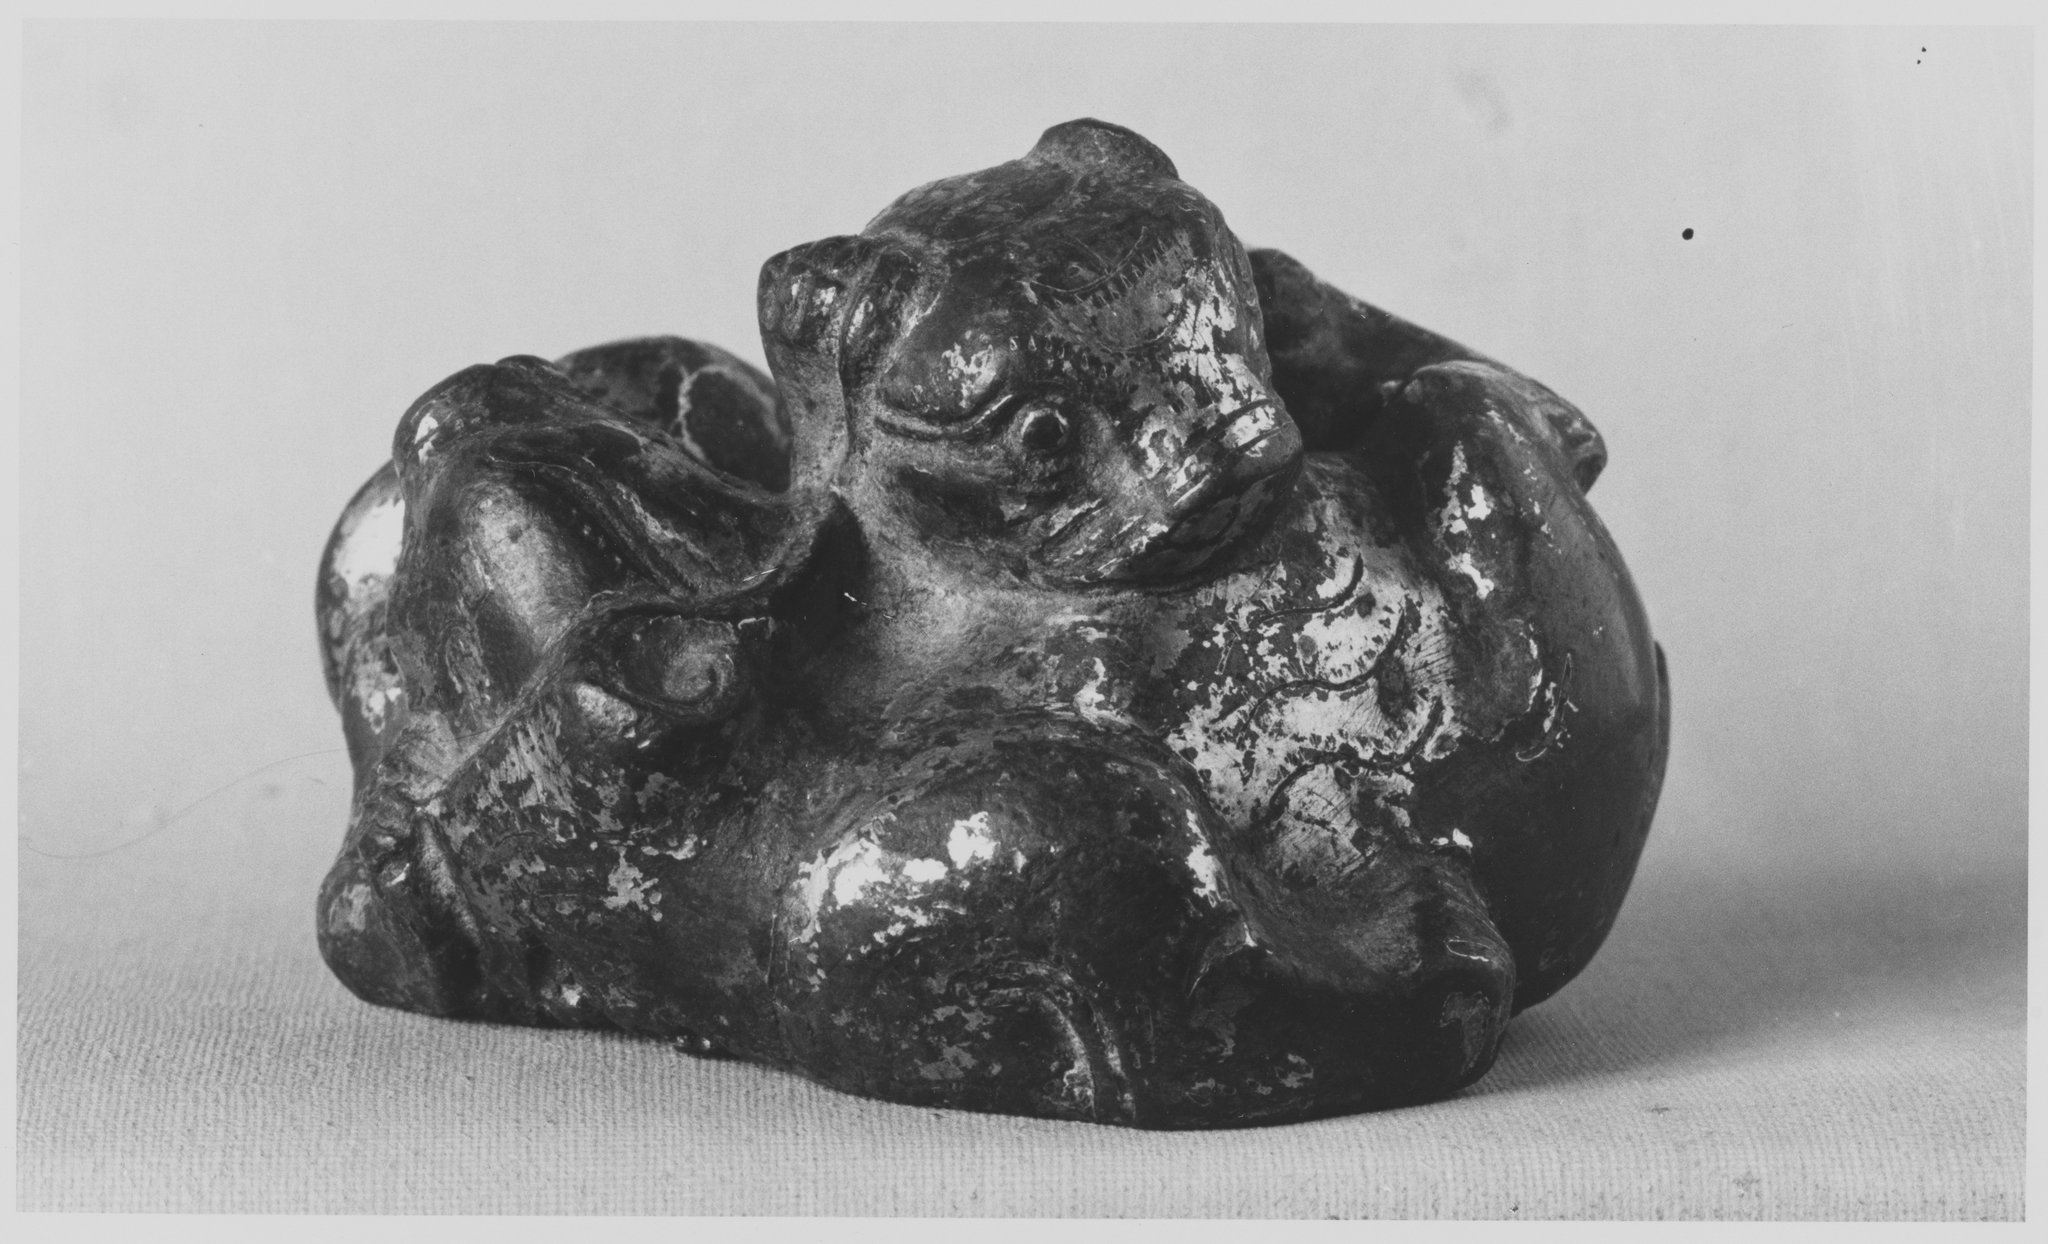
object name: weight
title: Mat Weight in the form of a Bear and Tiger in Combat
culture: chinese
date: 200-1 BCE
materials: gilt bronze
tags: bears